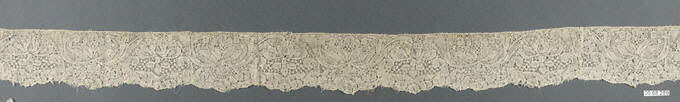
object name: strip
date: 1667-1700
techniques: lace